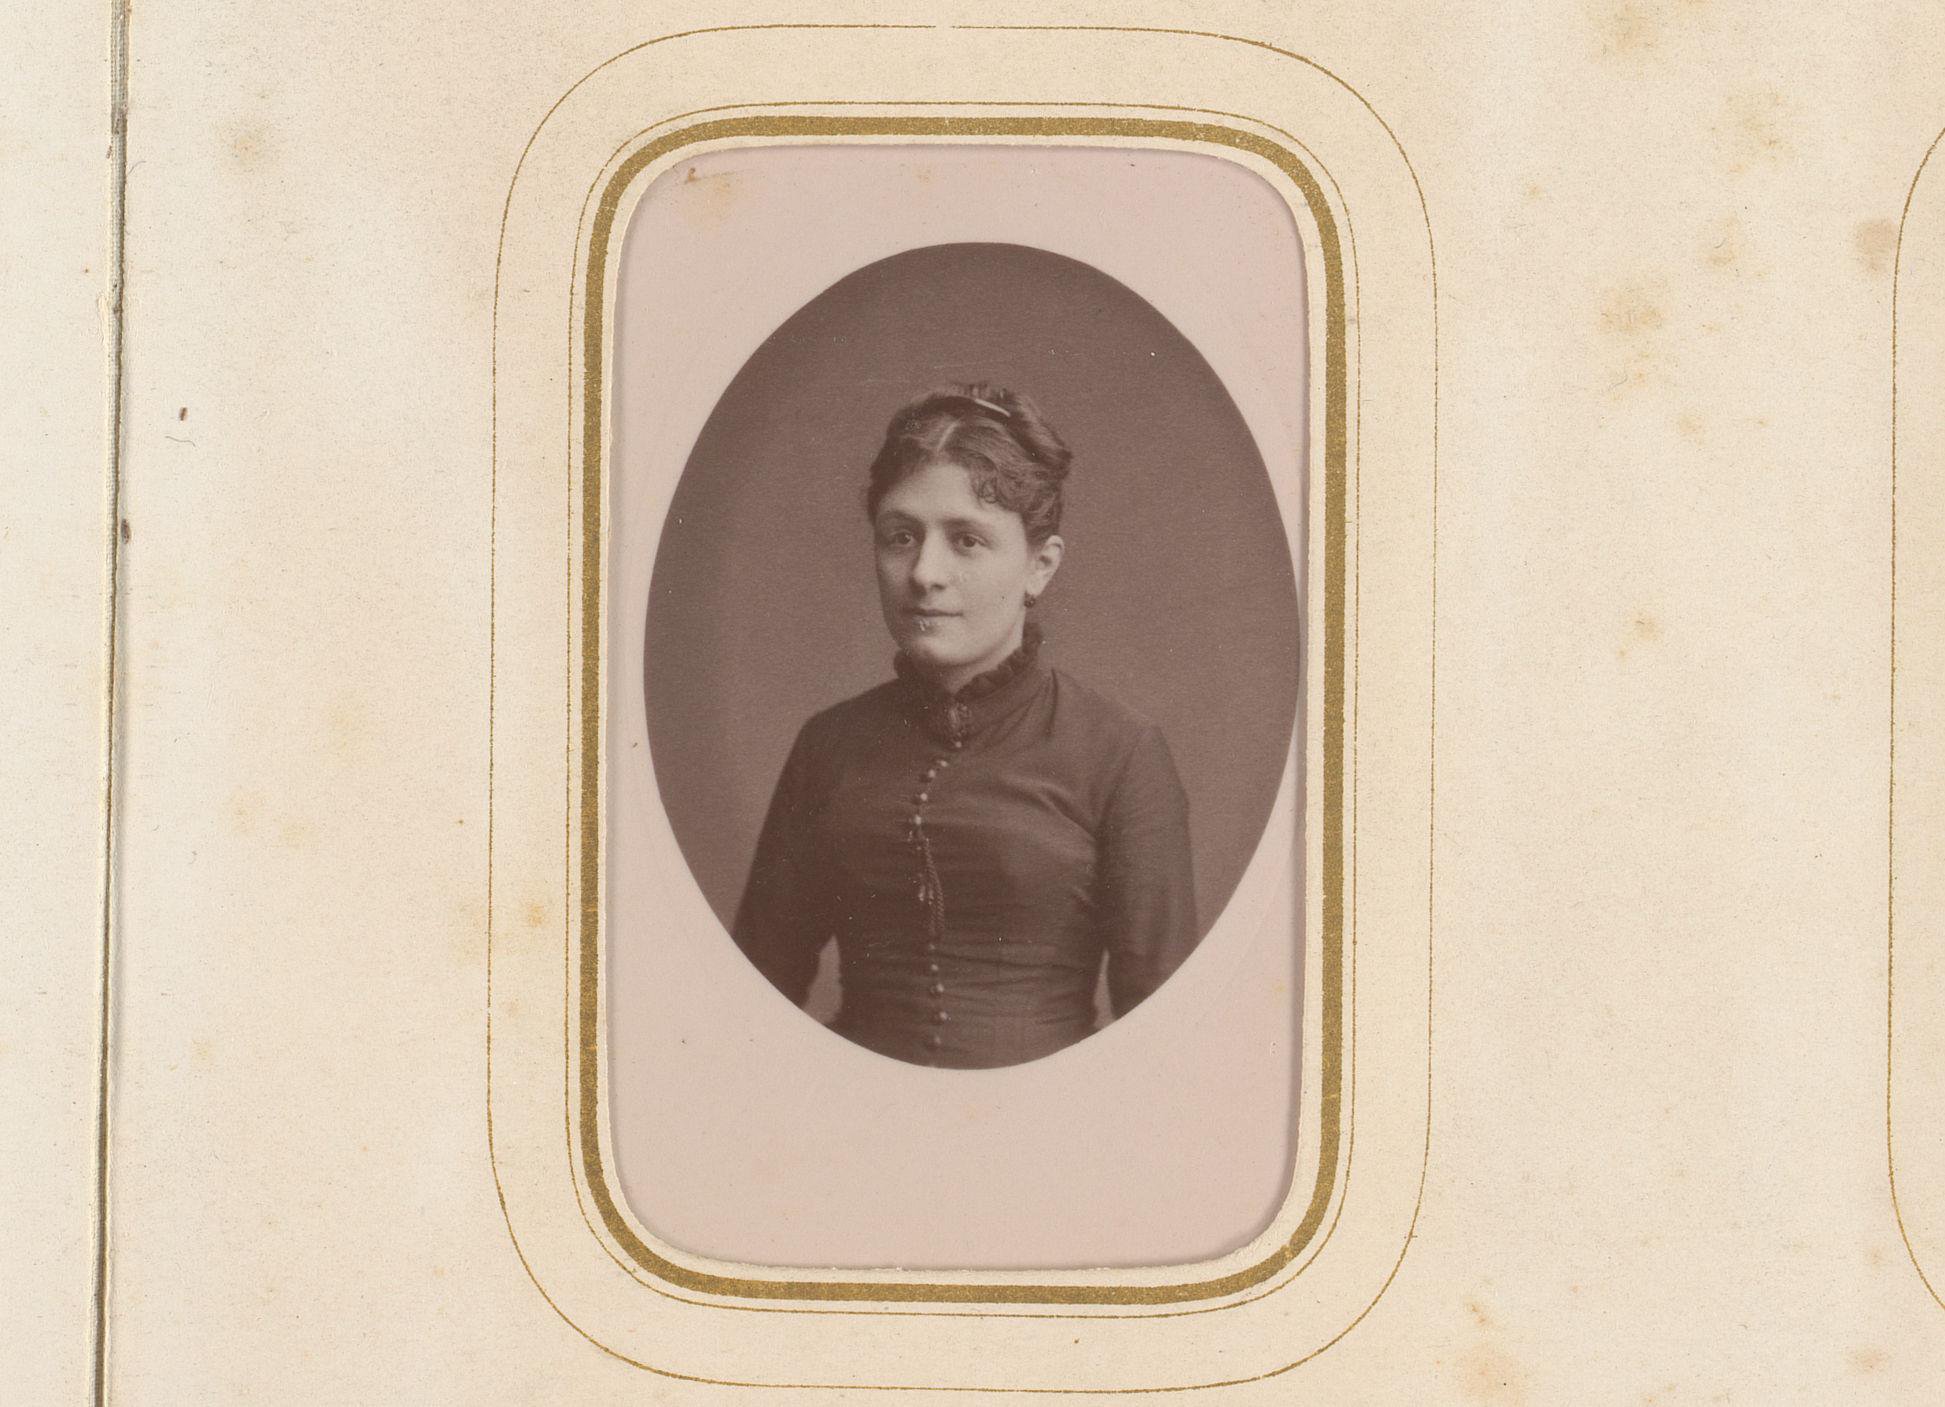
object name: album leaf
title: Portret van een vrouw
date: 1880-1900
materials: cardboard, celluloid, photographic support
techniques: albumen print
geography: paris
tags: historical persons - bb - woman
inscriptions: inscription: ‘Photographie de la Porte st. Denis/ France/ Photographie/ des députés de la Seine/ et du Conseil Municipal/ Paris/ 3/ Boulevard Bonne-Nouvelle’, inscription: ‘Photographie France/ 3, Boulevard Bonne-Nouvelle, Paris’